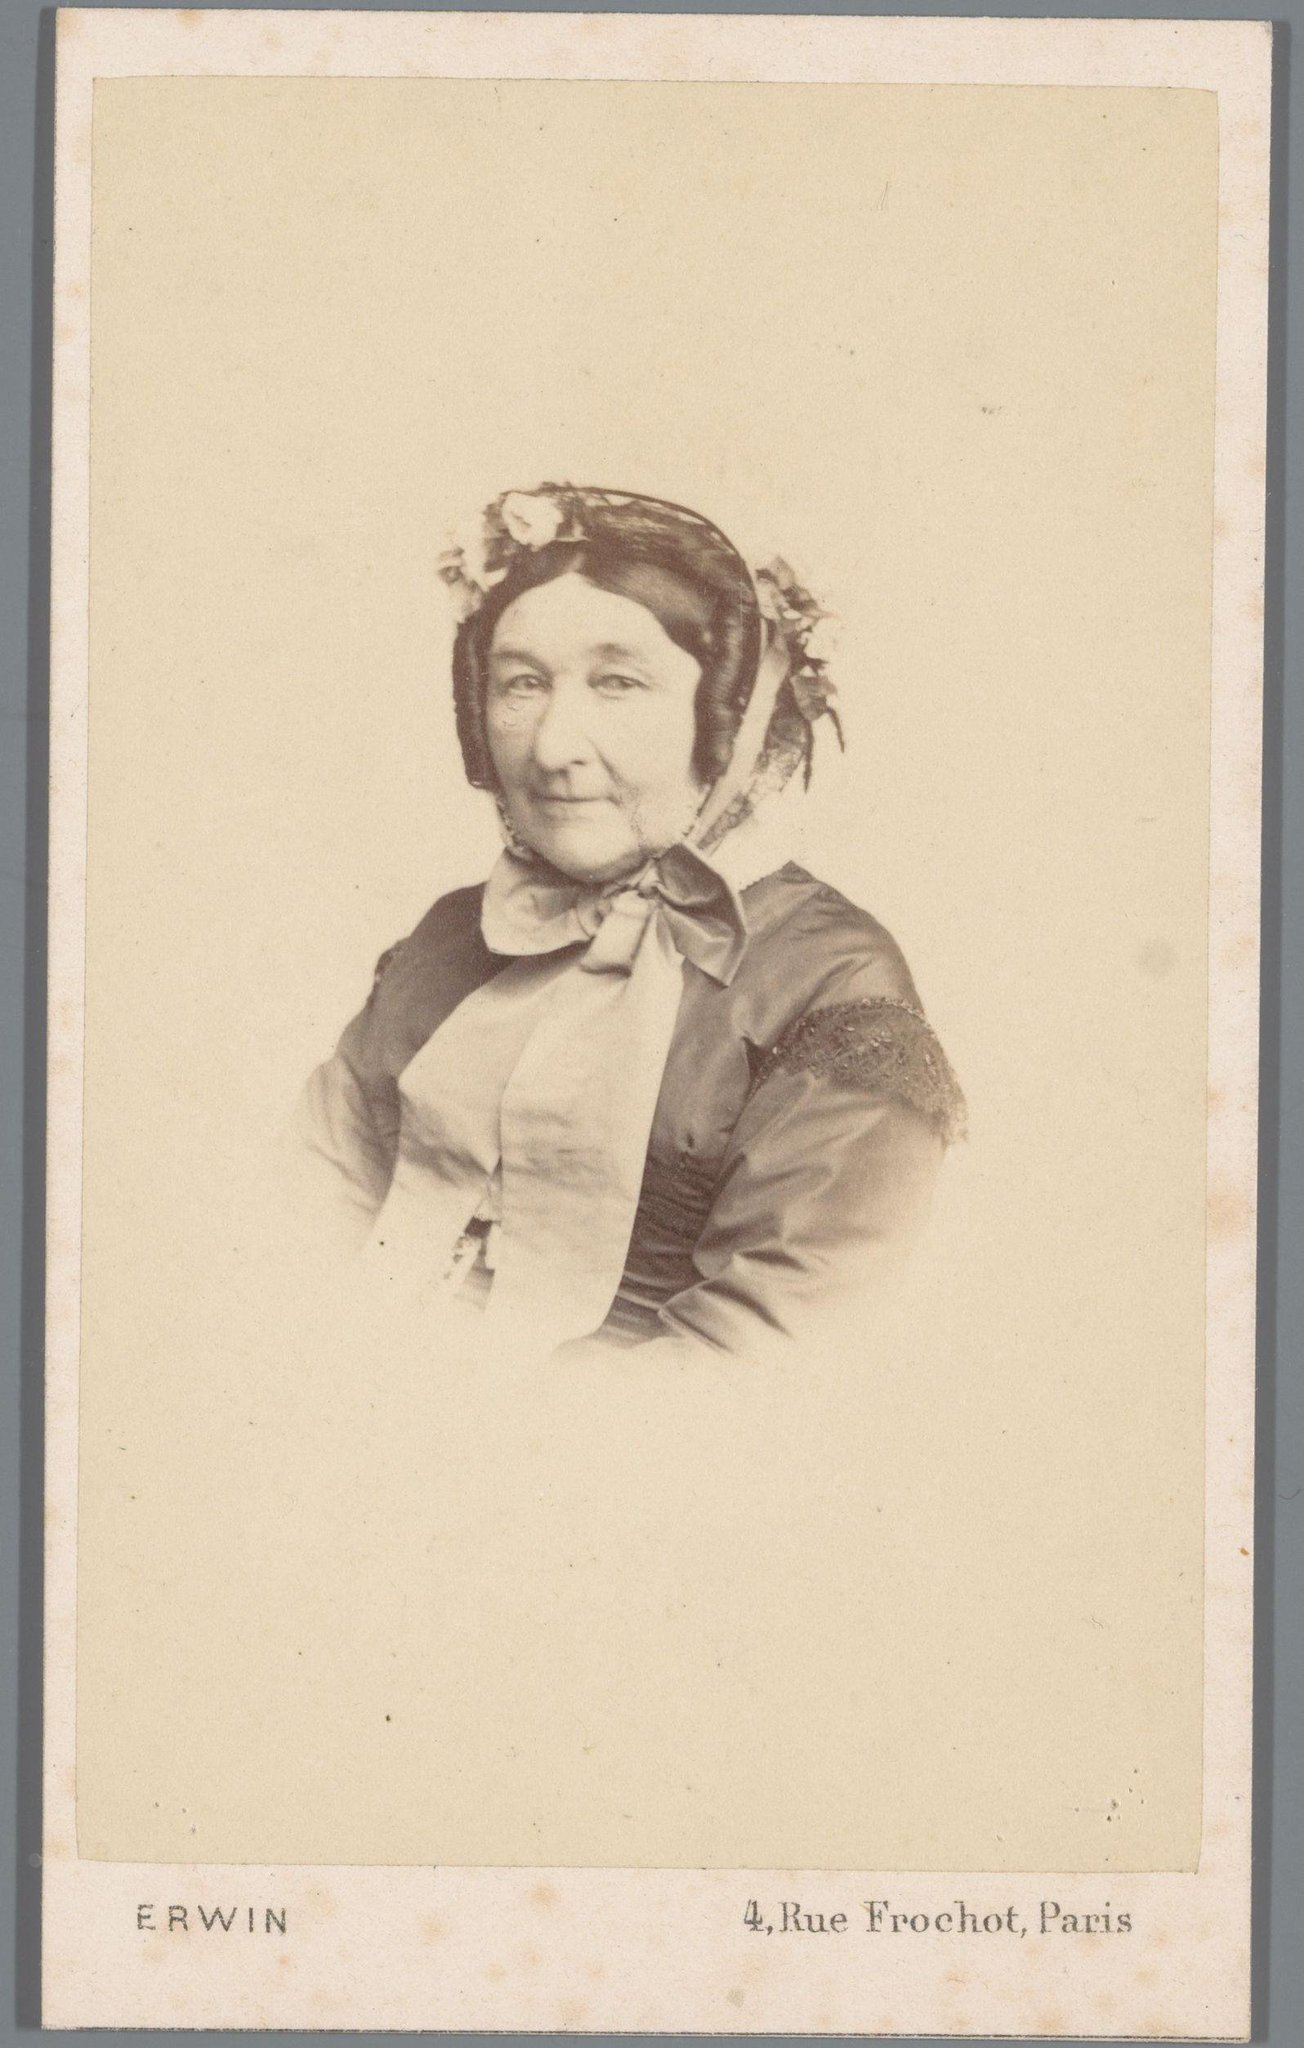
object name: carte de visite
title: Portret van een onbekende vrouw, aangeduid als Madame Papin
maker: erwin hanfstaengl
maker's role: fotograaf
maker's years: 1837-1905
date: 1855-1885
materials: cardboard, paper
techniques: albumen print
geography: paris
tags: historical persons - bb - woman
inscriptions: inscription: ‘ERWIN/ HANFSTAENGL/ 4, Rue Frochot/ PARIS.’, inscription: ‘Madame Papin’